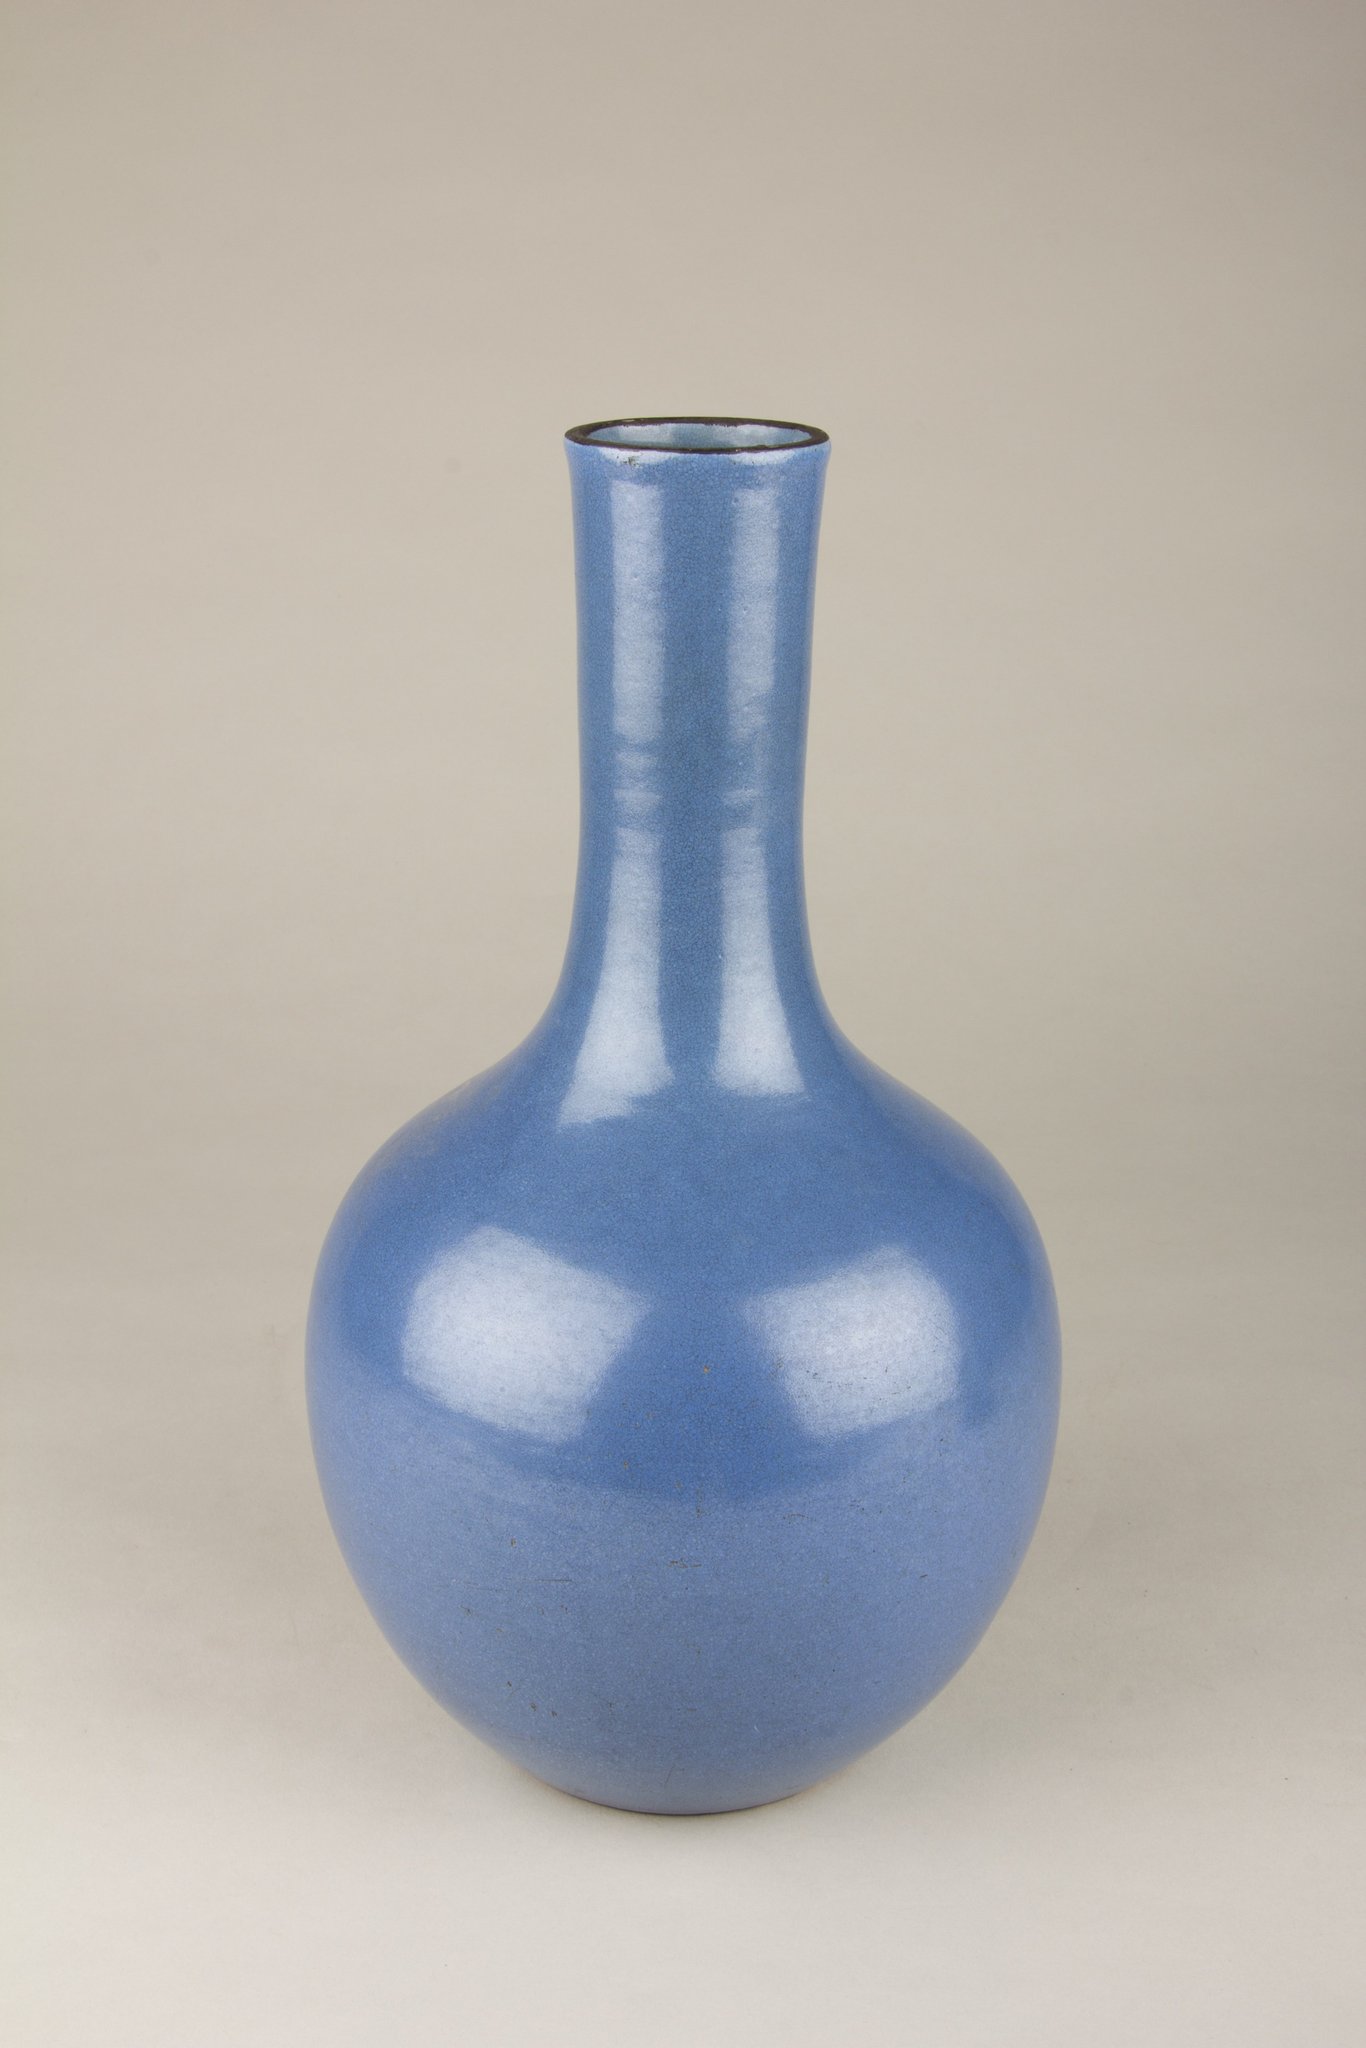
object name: bottle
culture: chinese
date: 1736-1795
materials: porcelain